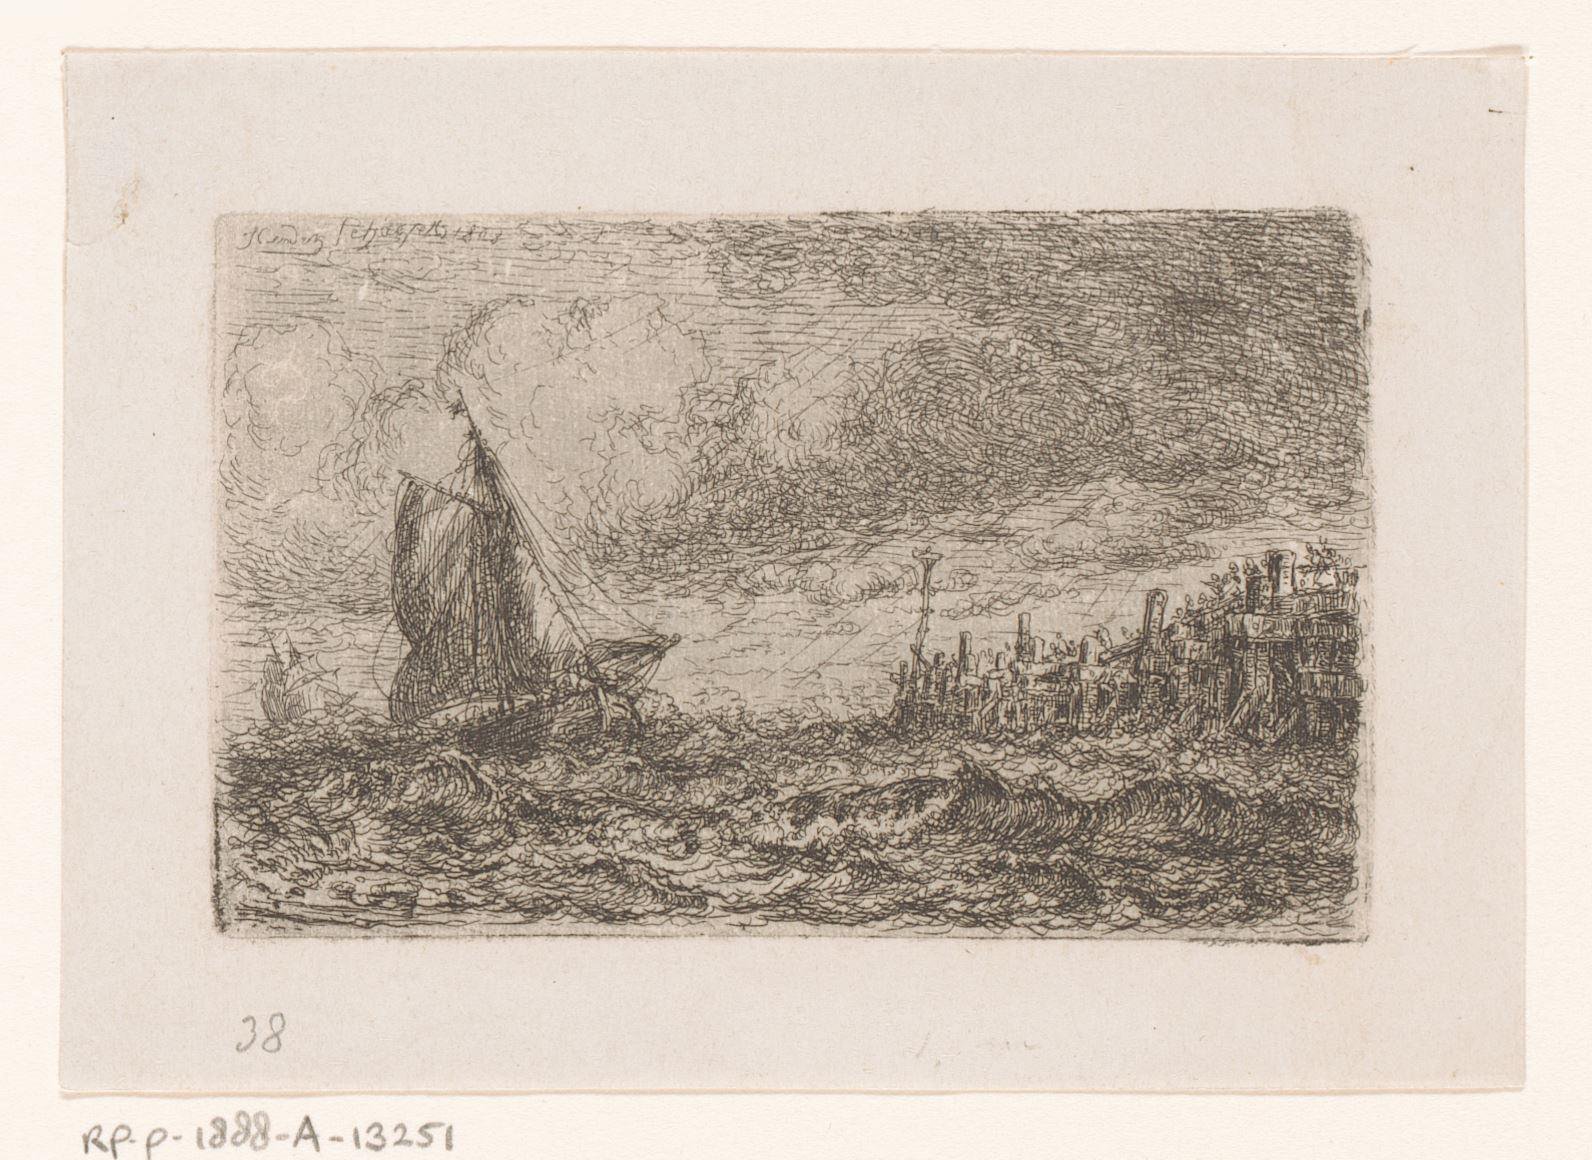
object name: print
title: Schepen op zee in een regenbui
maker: henri françois schaefels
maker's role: print maker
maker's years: 1827-1904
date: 1863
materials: paper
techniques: etching, intaglio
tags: sailing-ship, sailing-boat, landscapes with waters, waterscapes, seascapes (in the temperate zone), rain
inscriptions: collector's mark: Lugt 2228